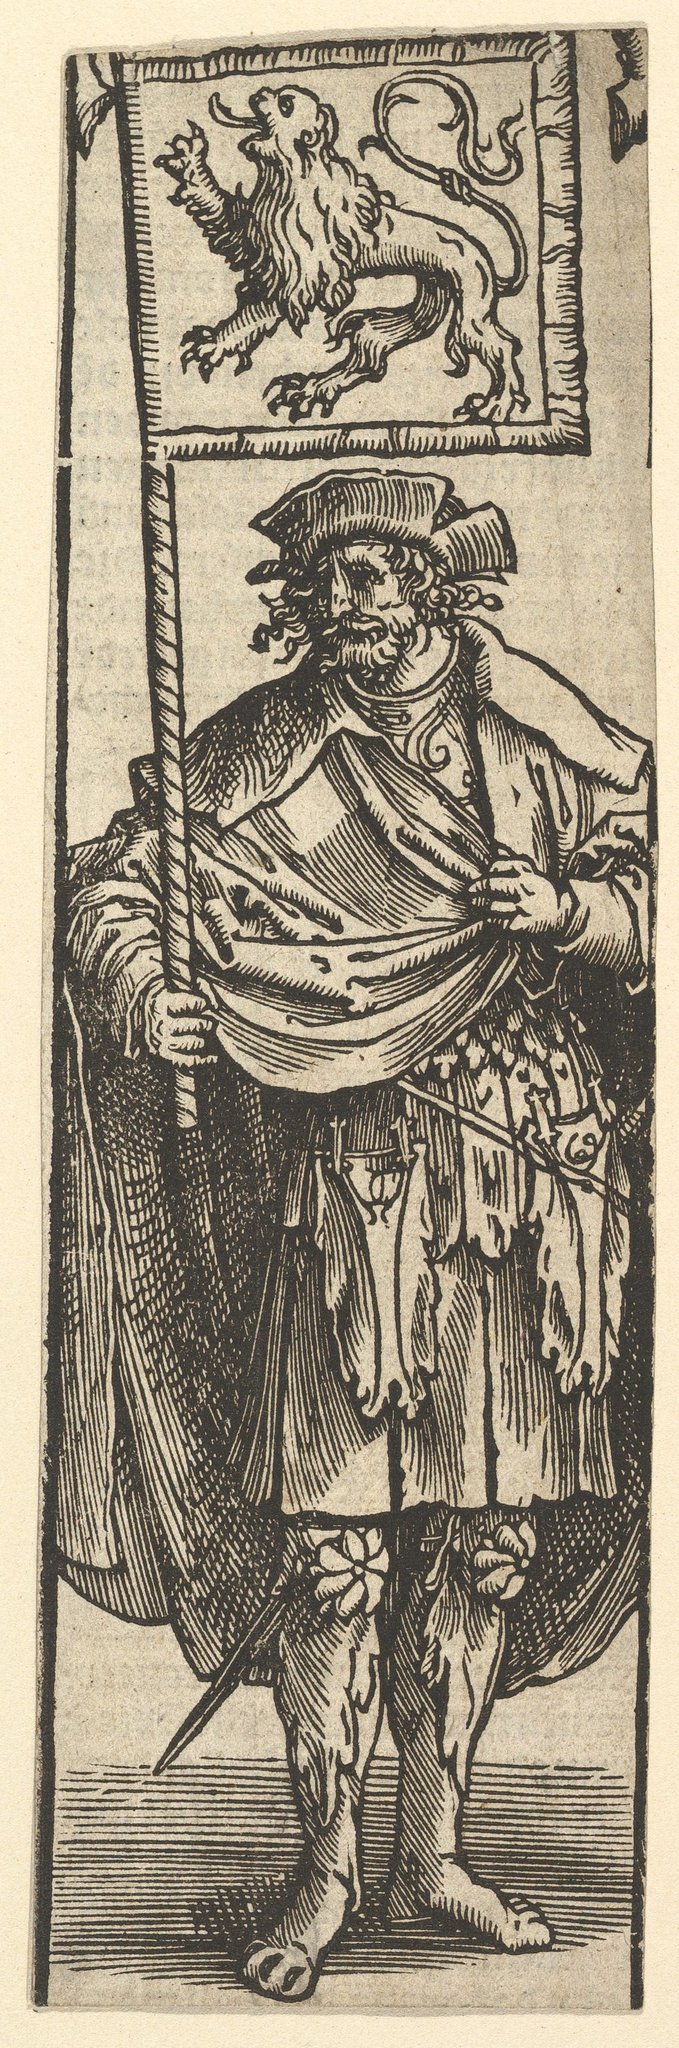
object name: print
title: Dirk First Count of Holland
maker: lucas van leyden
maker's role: artist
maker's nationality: netherlandish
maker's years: 1494-1533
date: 1517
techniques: woodcut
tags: men,lions,flags